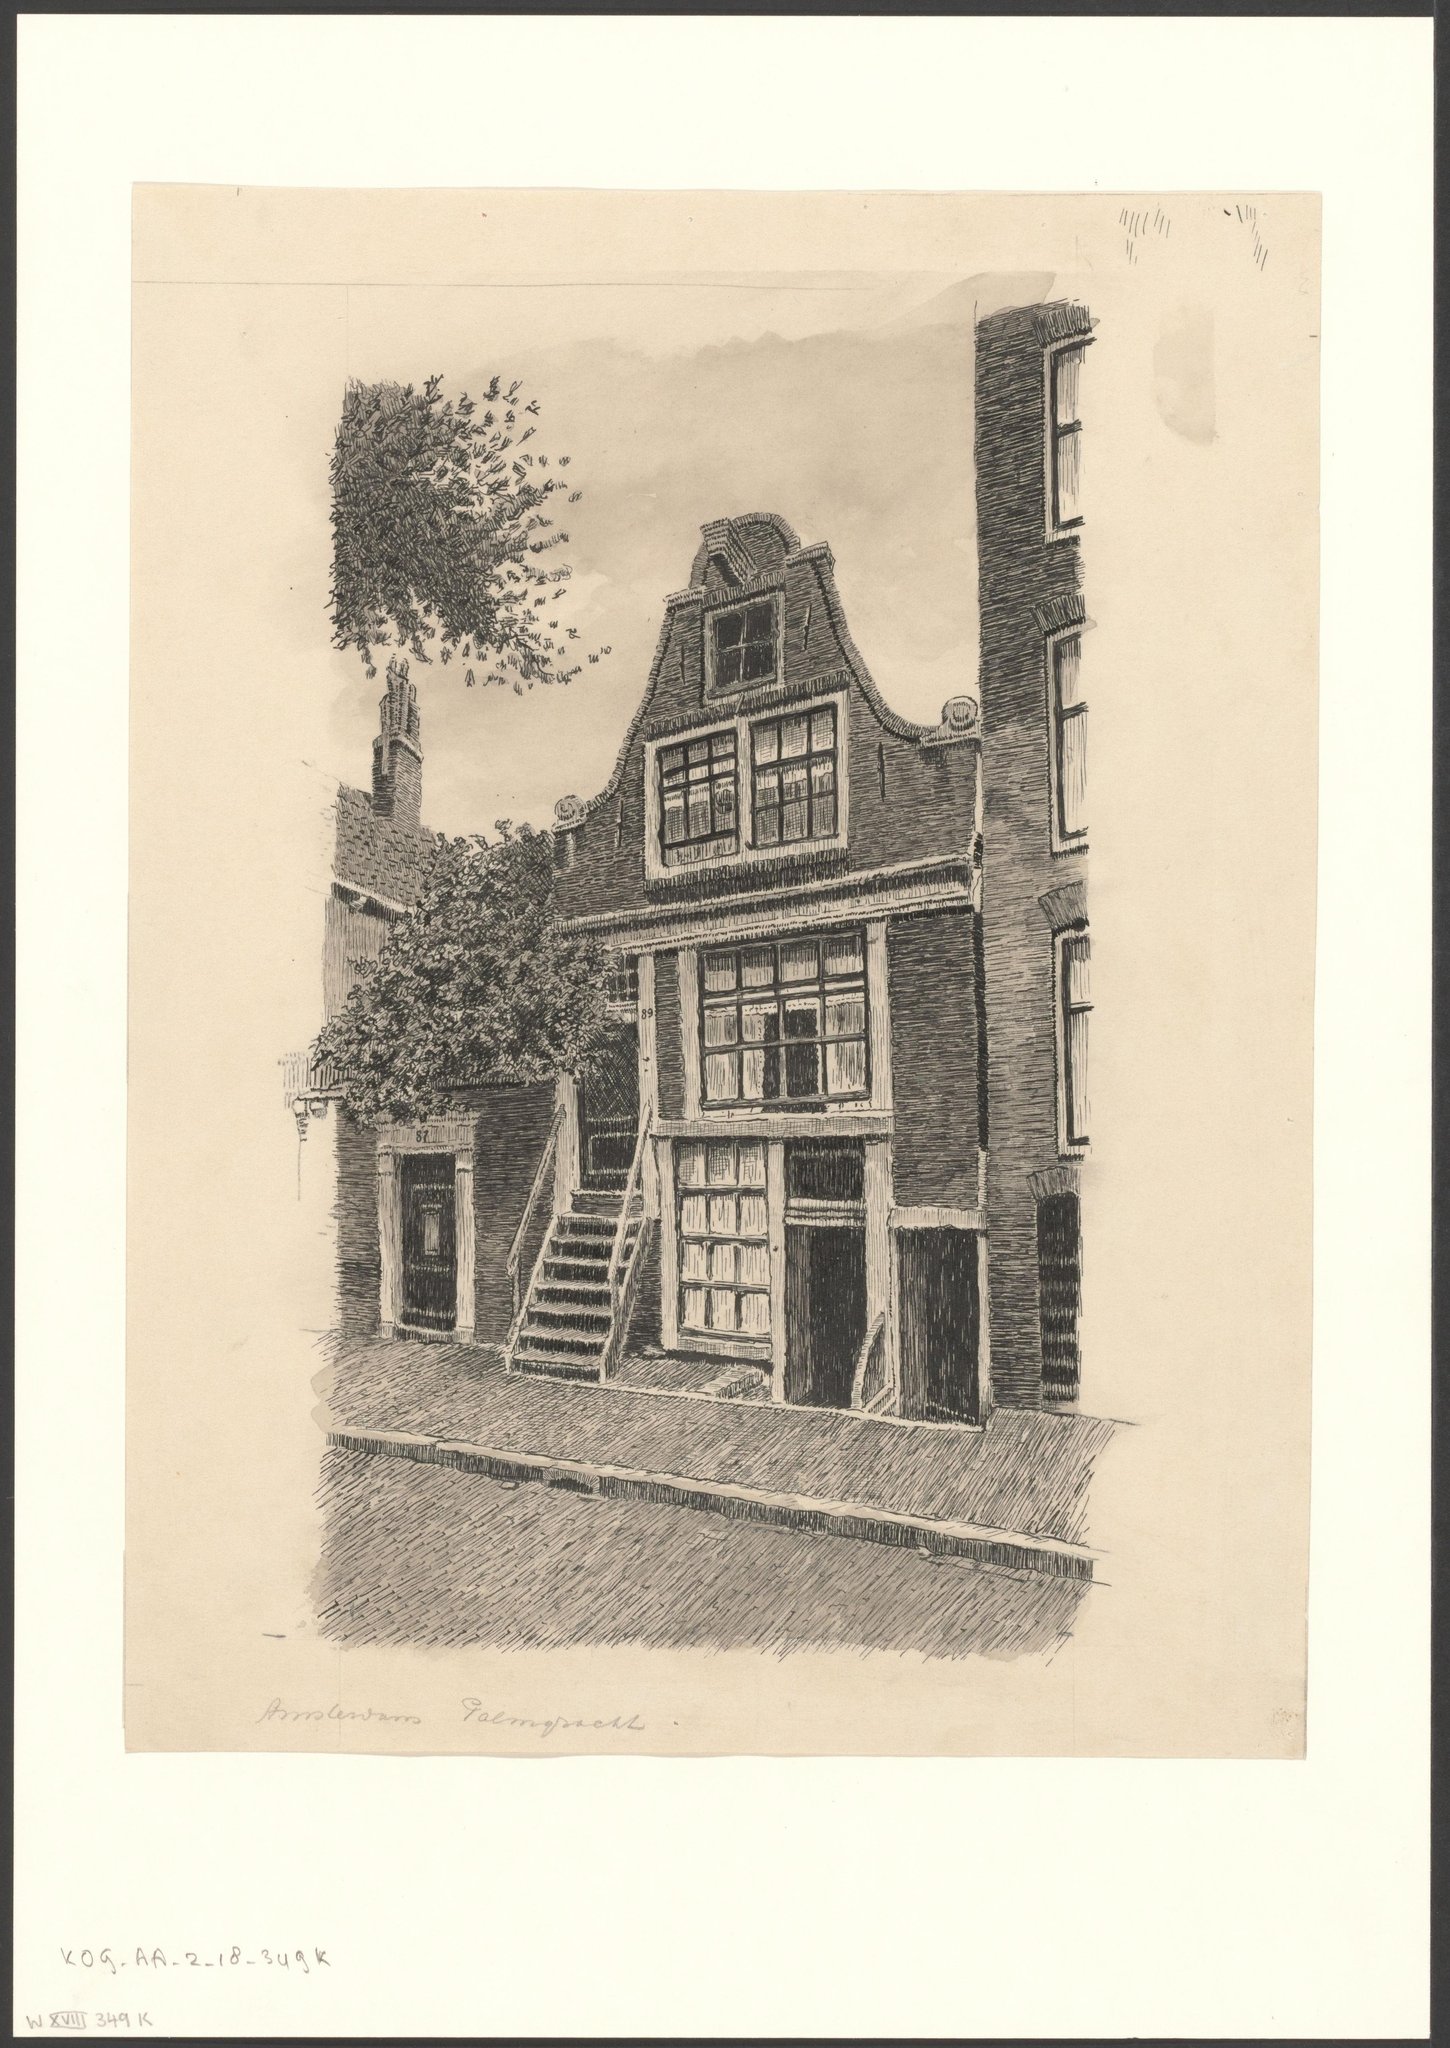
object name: drawing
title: Gezicht op een gebouw aan de Palmgracht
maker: Anonymous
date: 1875-1975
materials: ink, paper, pencil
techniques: brush, pen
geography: amsterdam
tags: city-view in general; 'veduta', canal, parts of church exterior and annexes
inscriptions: inscription: ‘Amsterdam Palmgracht’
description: Tekening binnen de Atlas Van Eck ingedeeld op wijknummer 18.